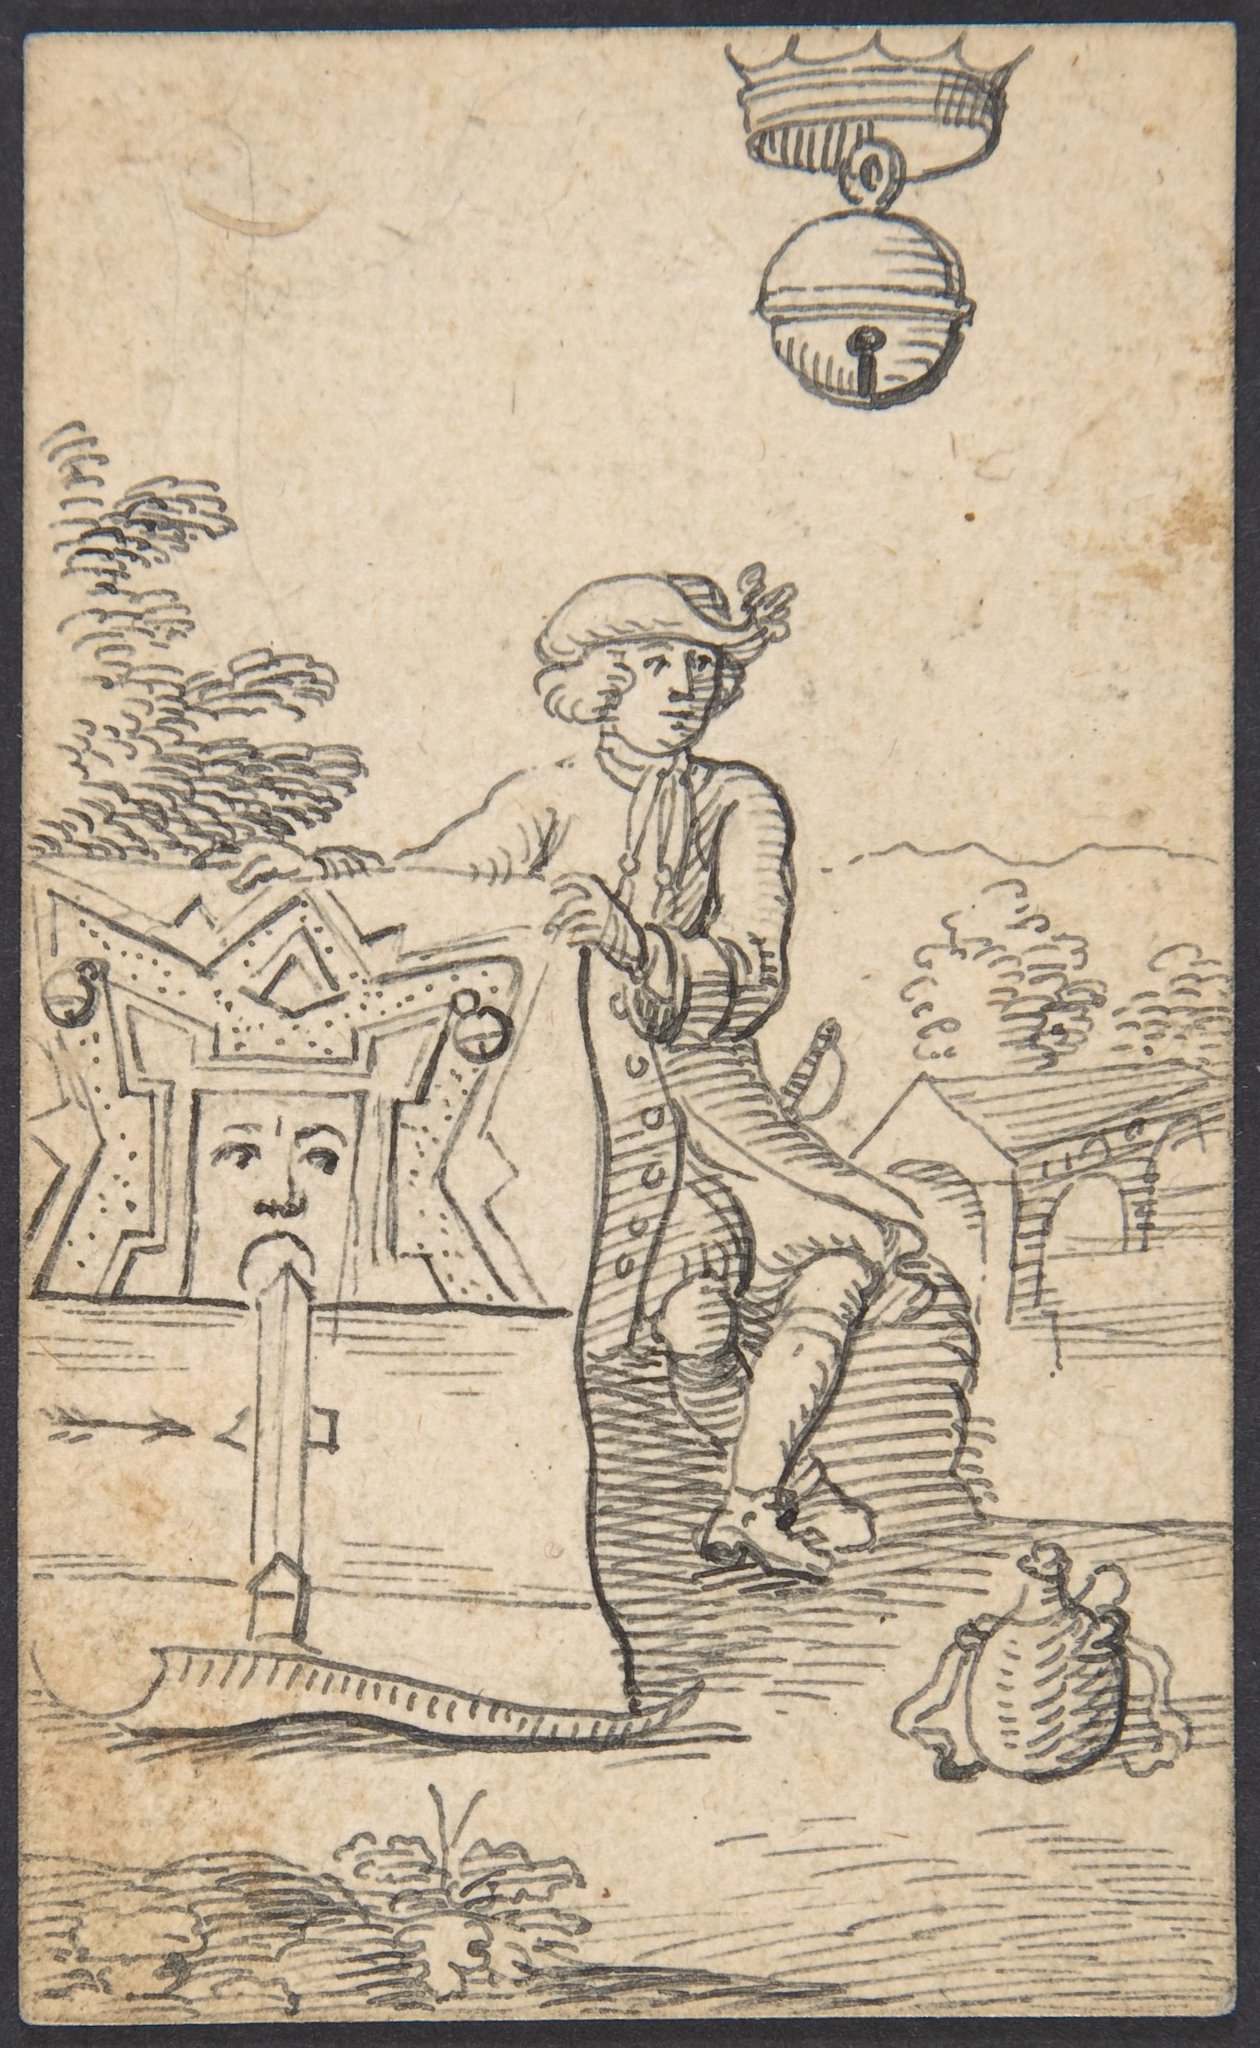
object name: drawing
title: Shell King: A Man with a Map of a Fortification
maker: johannes brandenberg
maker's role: artist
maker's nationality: swiss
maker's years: 1661-1729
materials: ink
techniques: pen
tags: men,maps